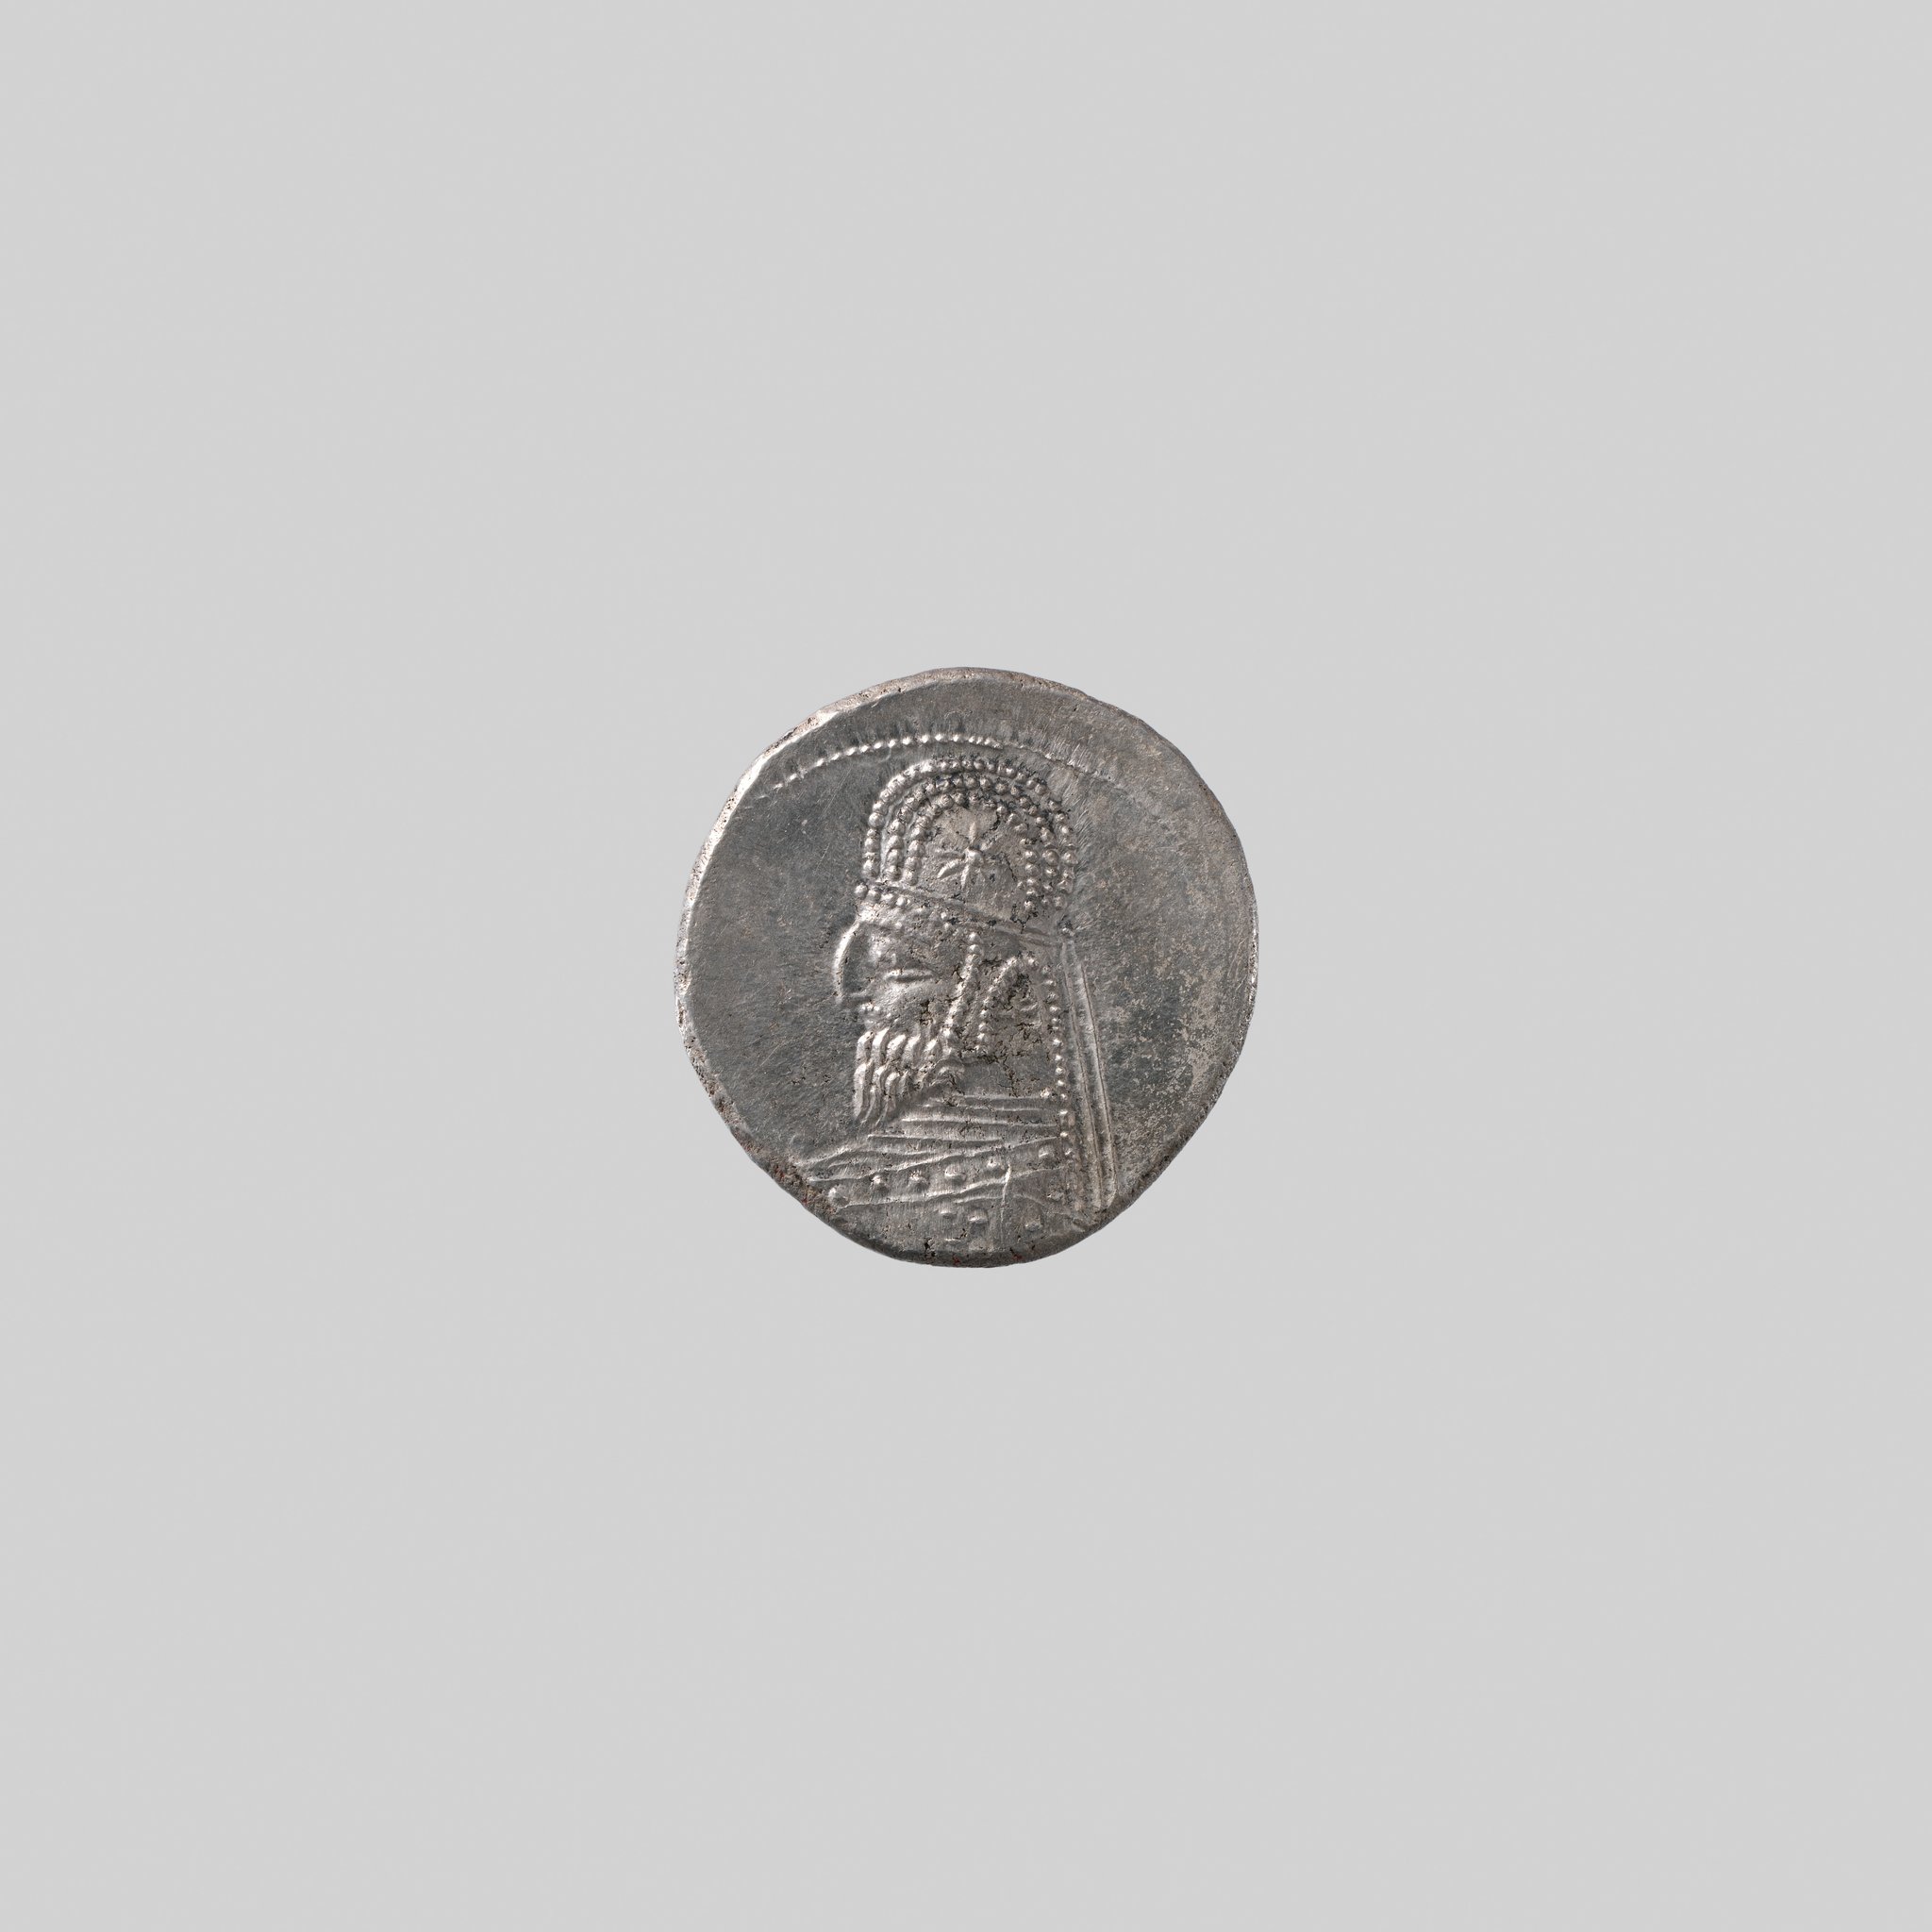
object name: coin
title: Drachm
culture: parthian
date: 100-50 BCE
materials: silver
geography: iran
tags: men,profiles